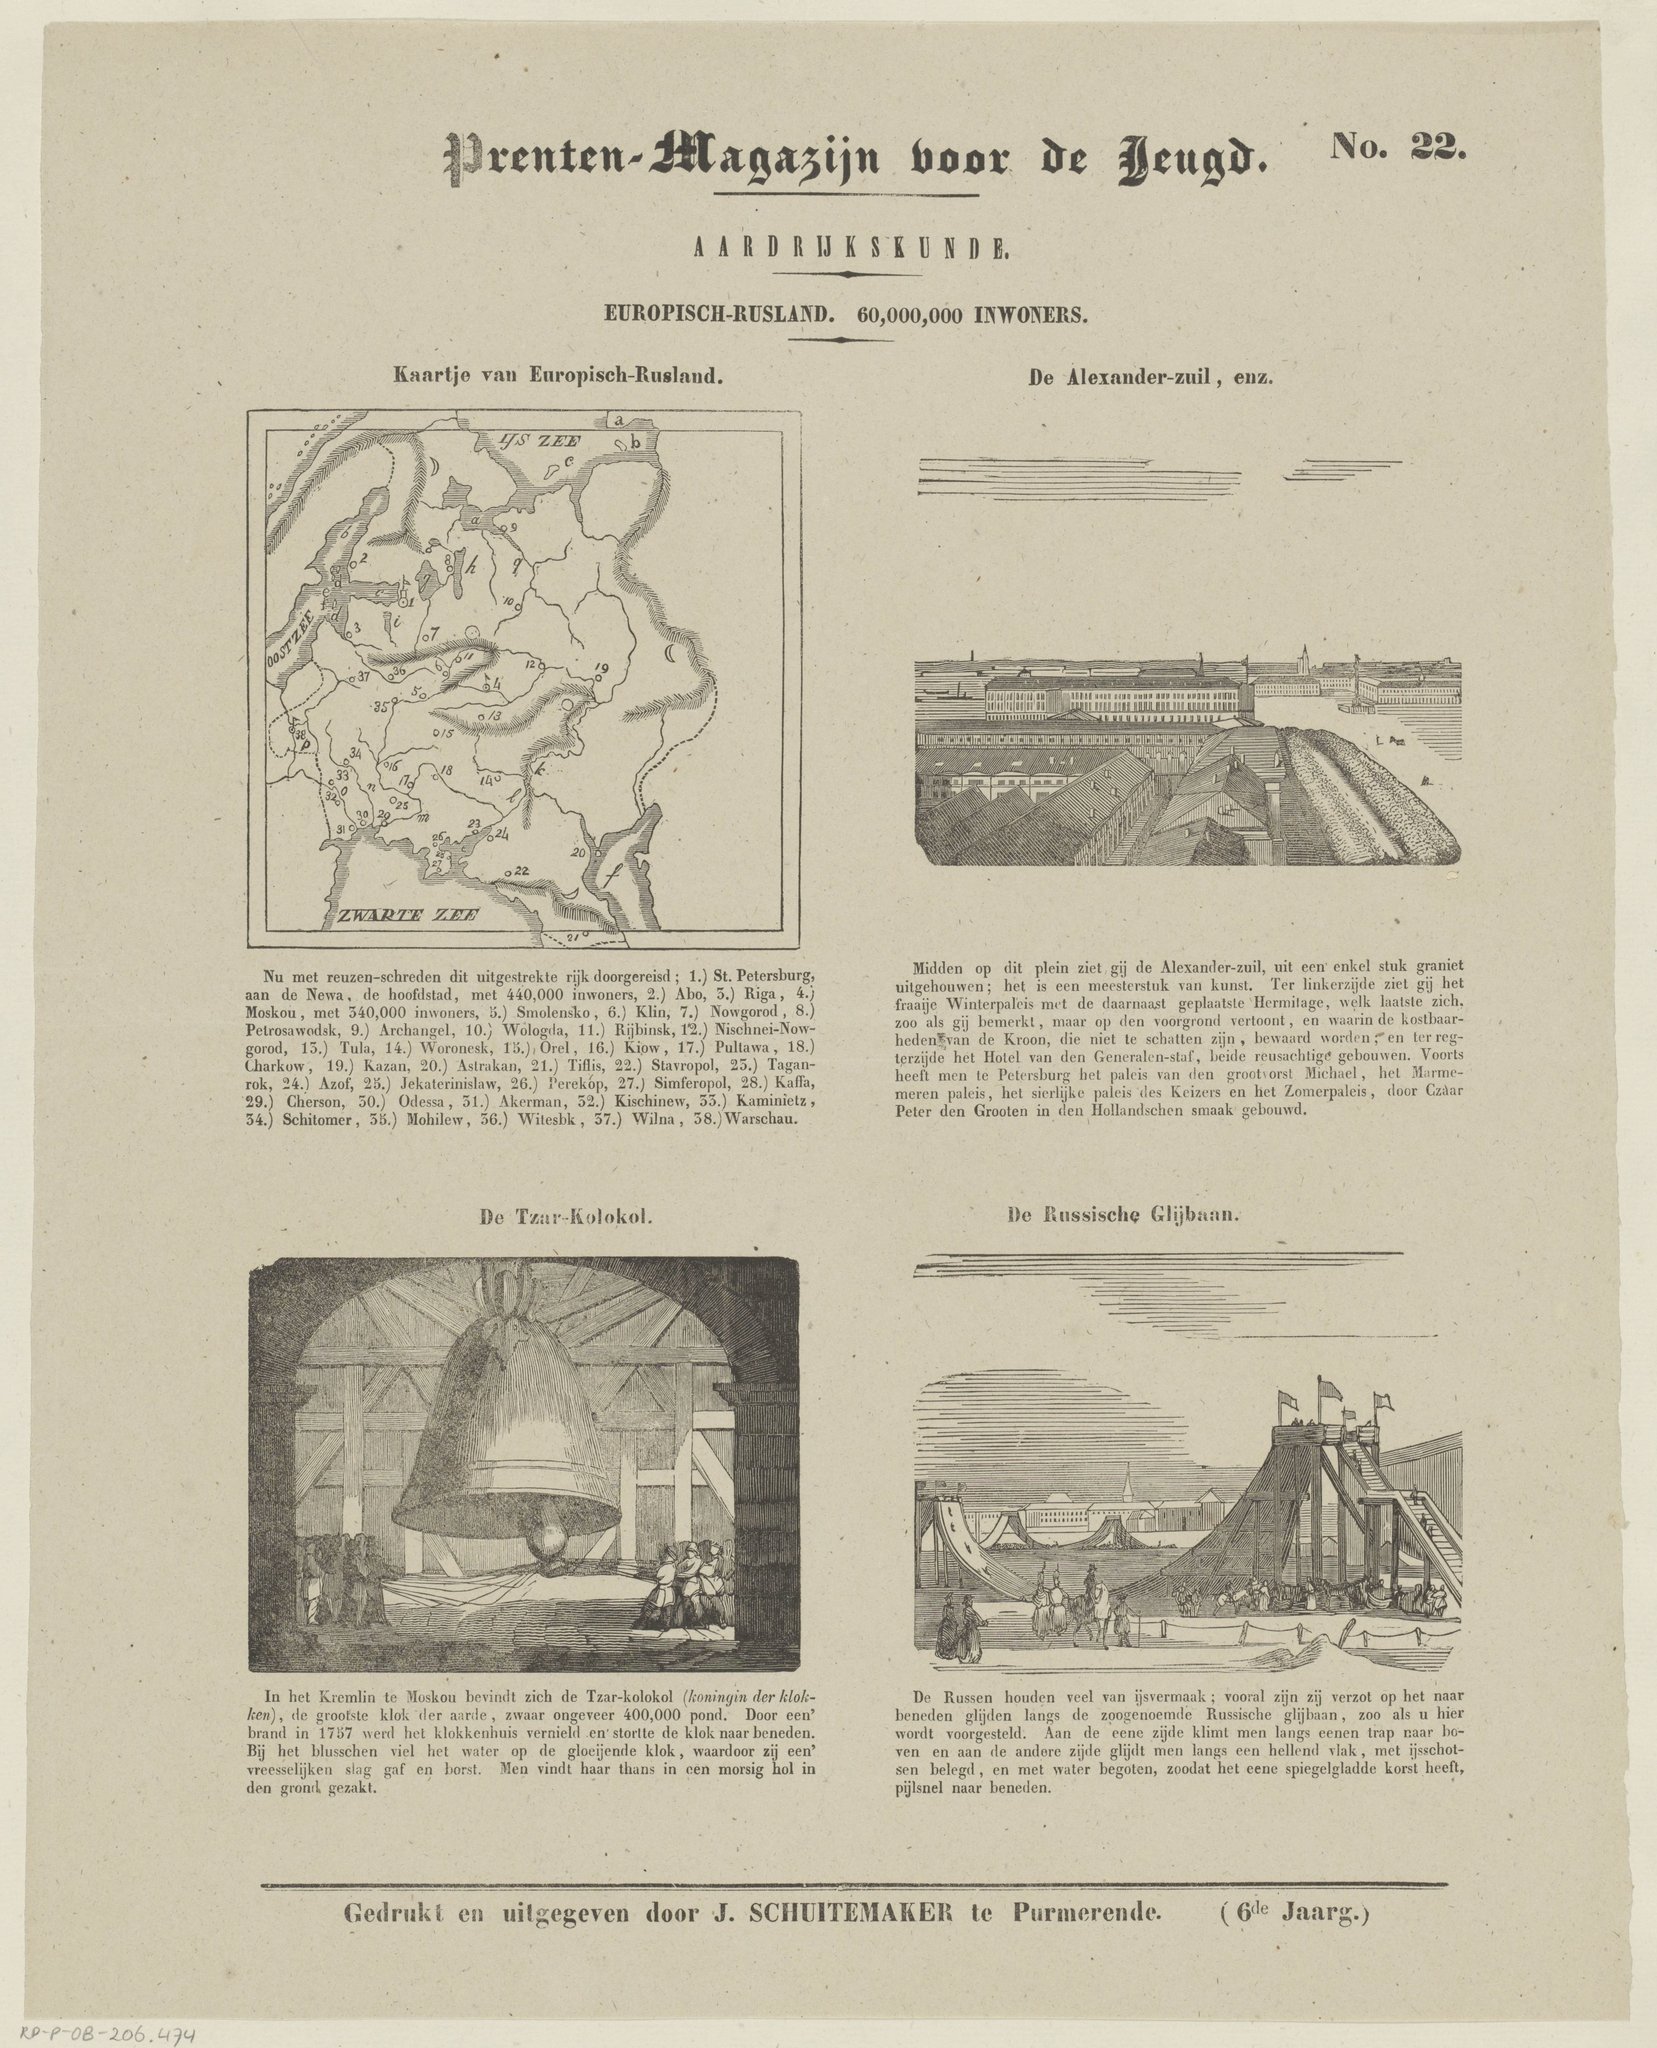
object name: print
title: Europisch-Rusland. 60,000,000 inwoners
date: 1847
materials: paper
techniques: letterpress printing, engraving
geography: purmerend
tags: maps, atlases, russia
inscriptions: collector's mark: Lugt 2760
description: Blad met 4 voorstellingen over Europisch-Rusland met een kaart en belangrijke monumenten, zoals de Alexenderzuil en de Tsarenklok. Boven elke voorstelling een titel en onder elke voorstelling een onderschrift. Genummerd rechtsboven: No. 22.